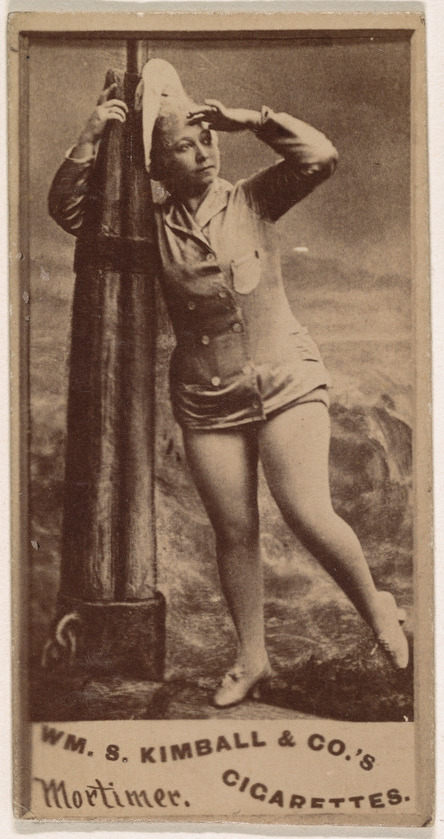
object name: photograph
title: Miss Mortimer, from the Actresses series (N203) issued by Wm. S. Kimball & Co.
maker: william s. kimball & company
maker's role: publisher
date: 1889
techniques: color lithograph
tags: portraits,women,actresses